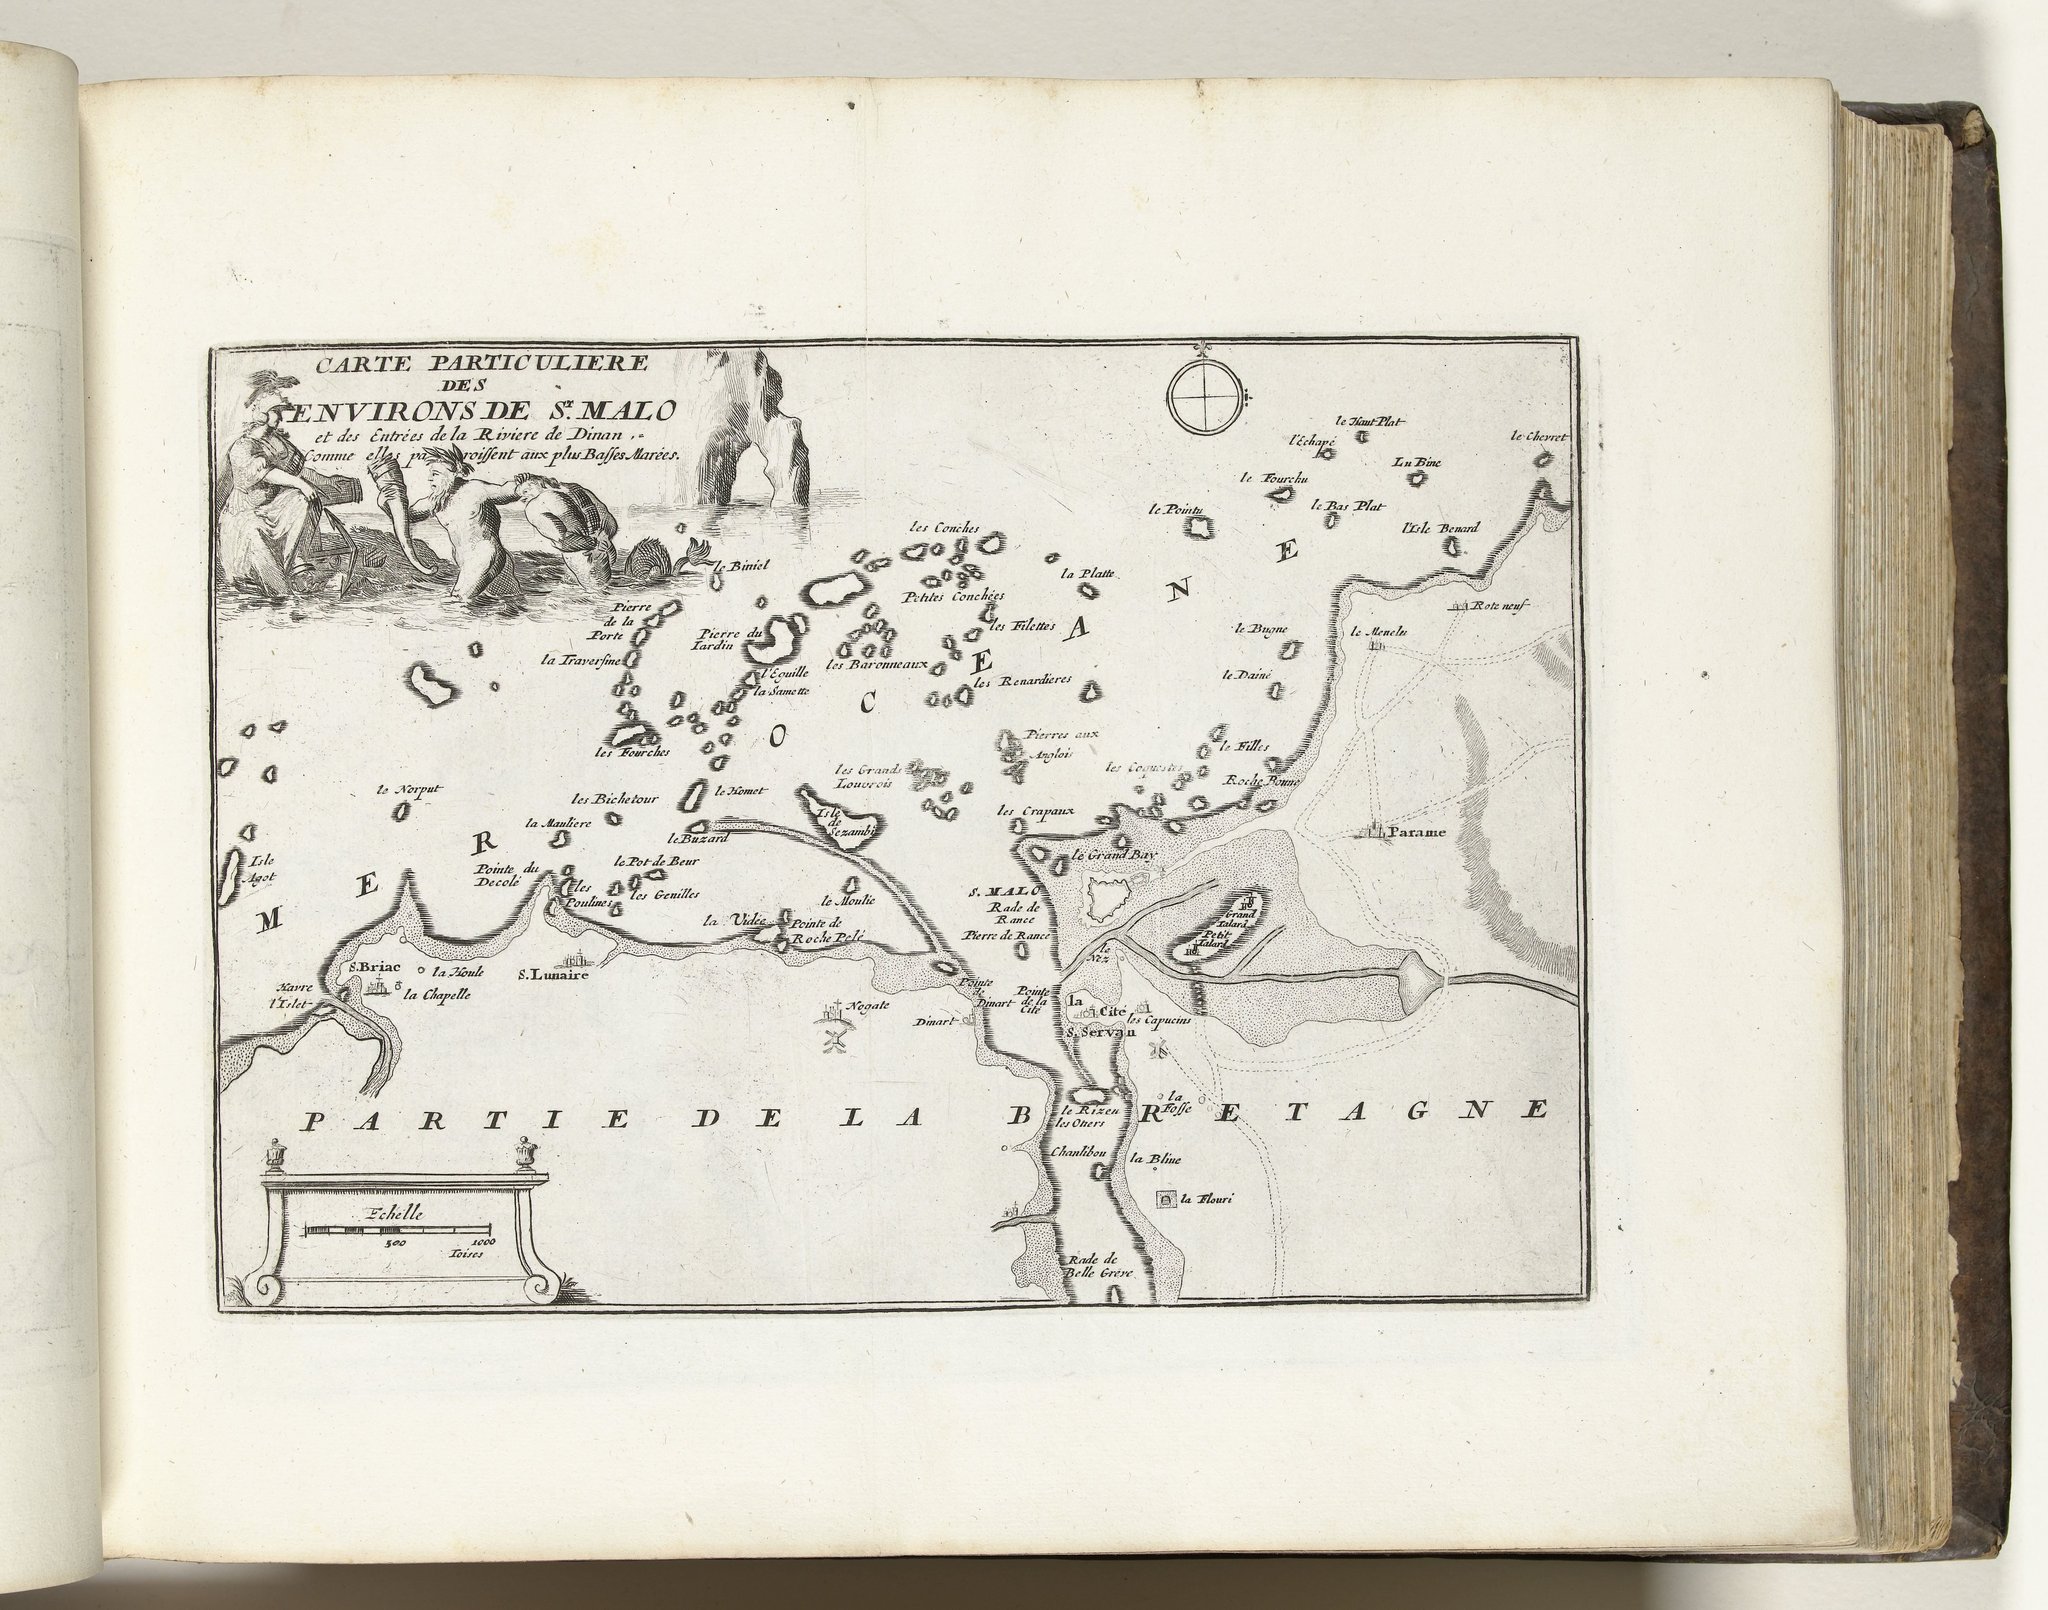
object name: map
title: Kaart van de omgeving van Saint-Malo, ca. 1693-1695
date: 1693-1695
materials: paper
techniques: engraving, etching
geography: france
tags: fortress, maps of separate countries or regions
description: Kaart van de omgeving van de Franse stad Saint-Malo. Onderdeel van het derde deel (1695) van het prentwerk waarin gebundeld zijn de acht delen van Les forces de l'Europe uitgegeven tussen 1693-1697. Het prentwerk bestaat uit 175 platen met plannen (afkomstig van Sébastien Le Prestre, Seigneur de Vauban) van vermaarde sterke steden en vestingen in de Negenjarige Oorlog. Titel en opschriften in het Frans.